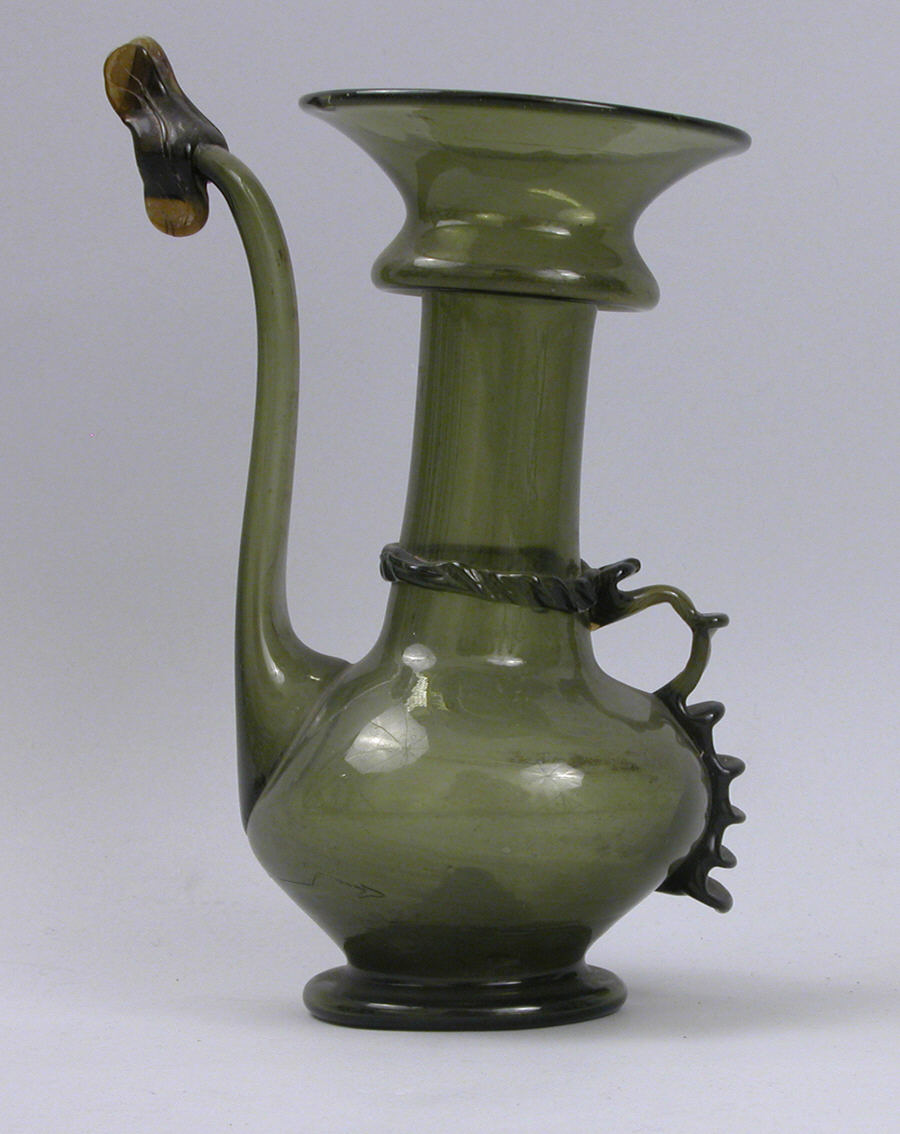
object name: ewer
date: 1701-1900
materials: glass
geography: iran